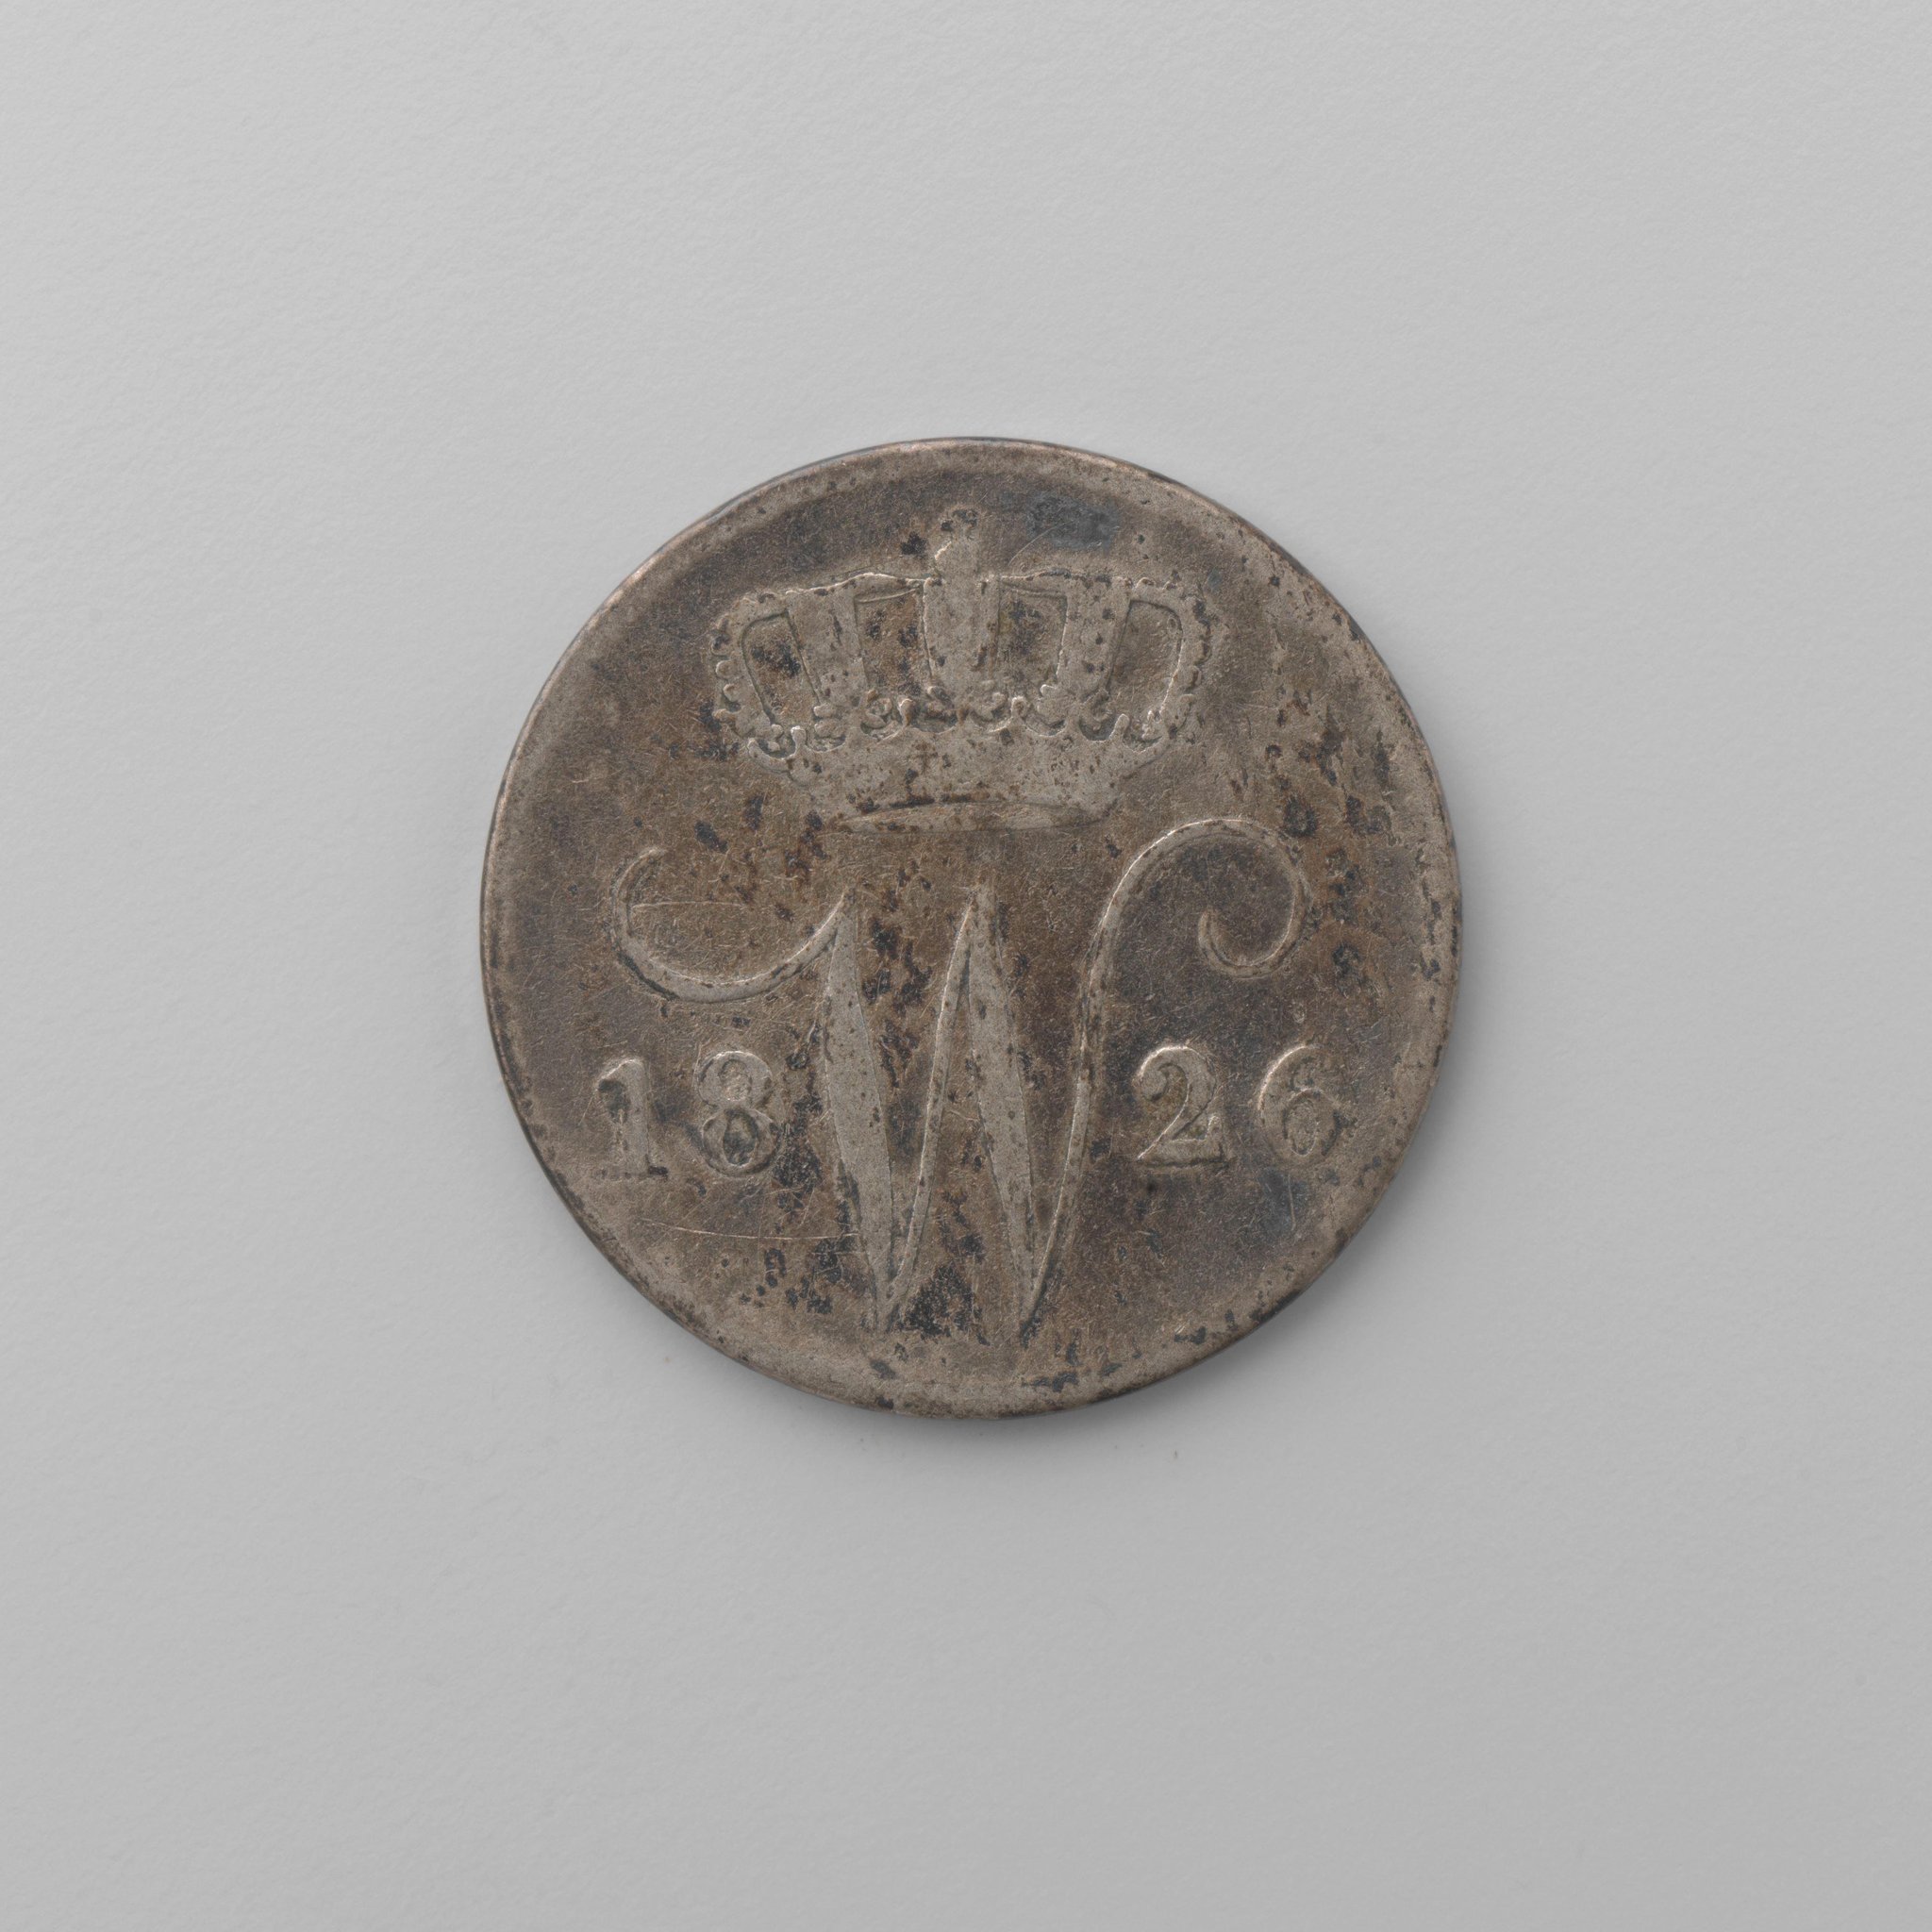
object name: coin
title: Nederlandse 25 cent, 1826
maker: william i of the netherlands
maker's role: koning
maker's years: 1772-1843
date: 1826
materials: silver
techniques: striking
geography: brussels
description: Zilveren munt. Voorzijde: tussen jaartal gekroonde cursieve letter W. Keerzijde: tussen waarde-aanduiding 25 C. gekroond rijkswapenschild. Gladde rand.